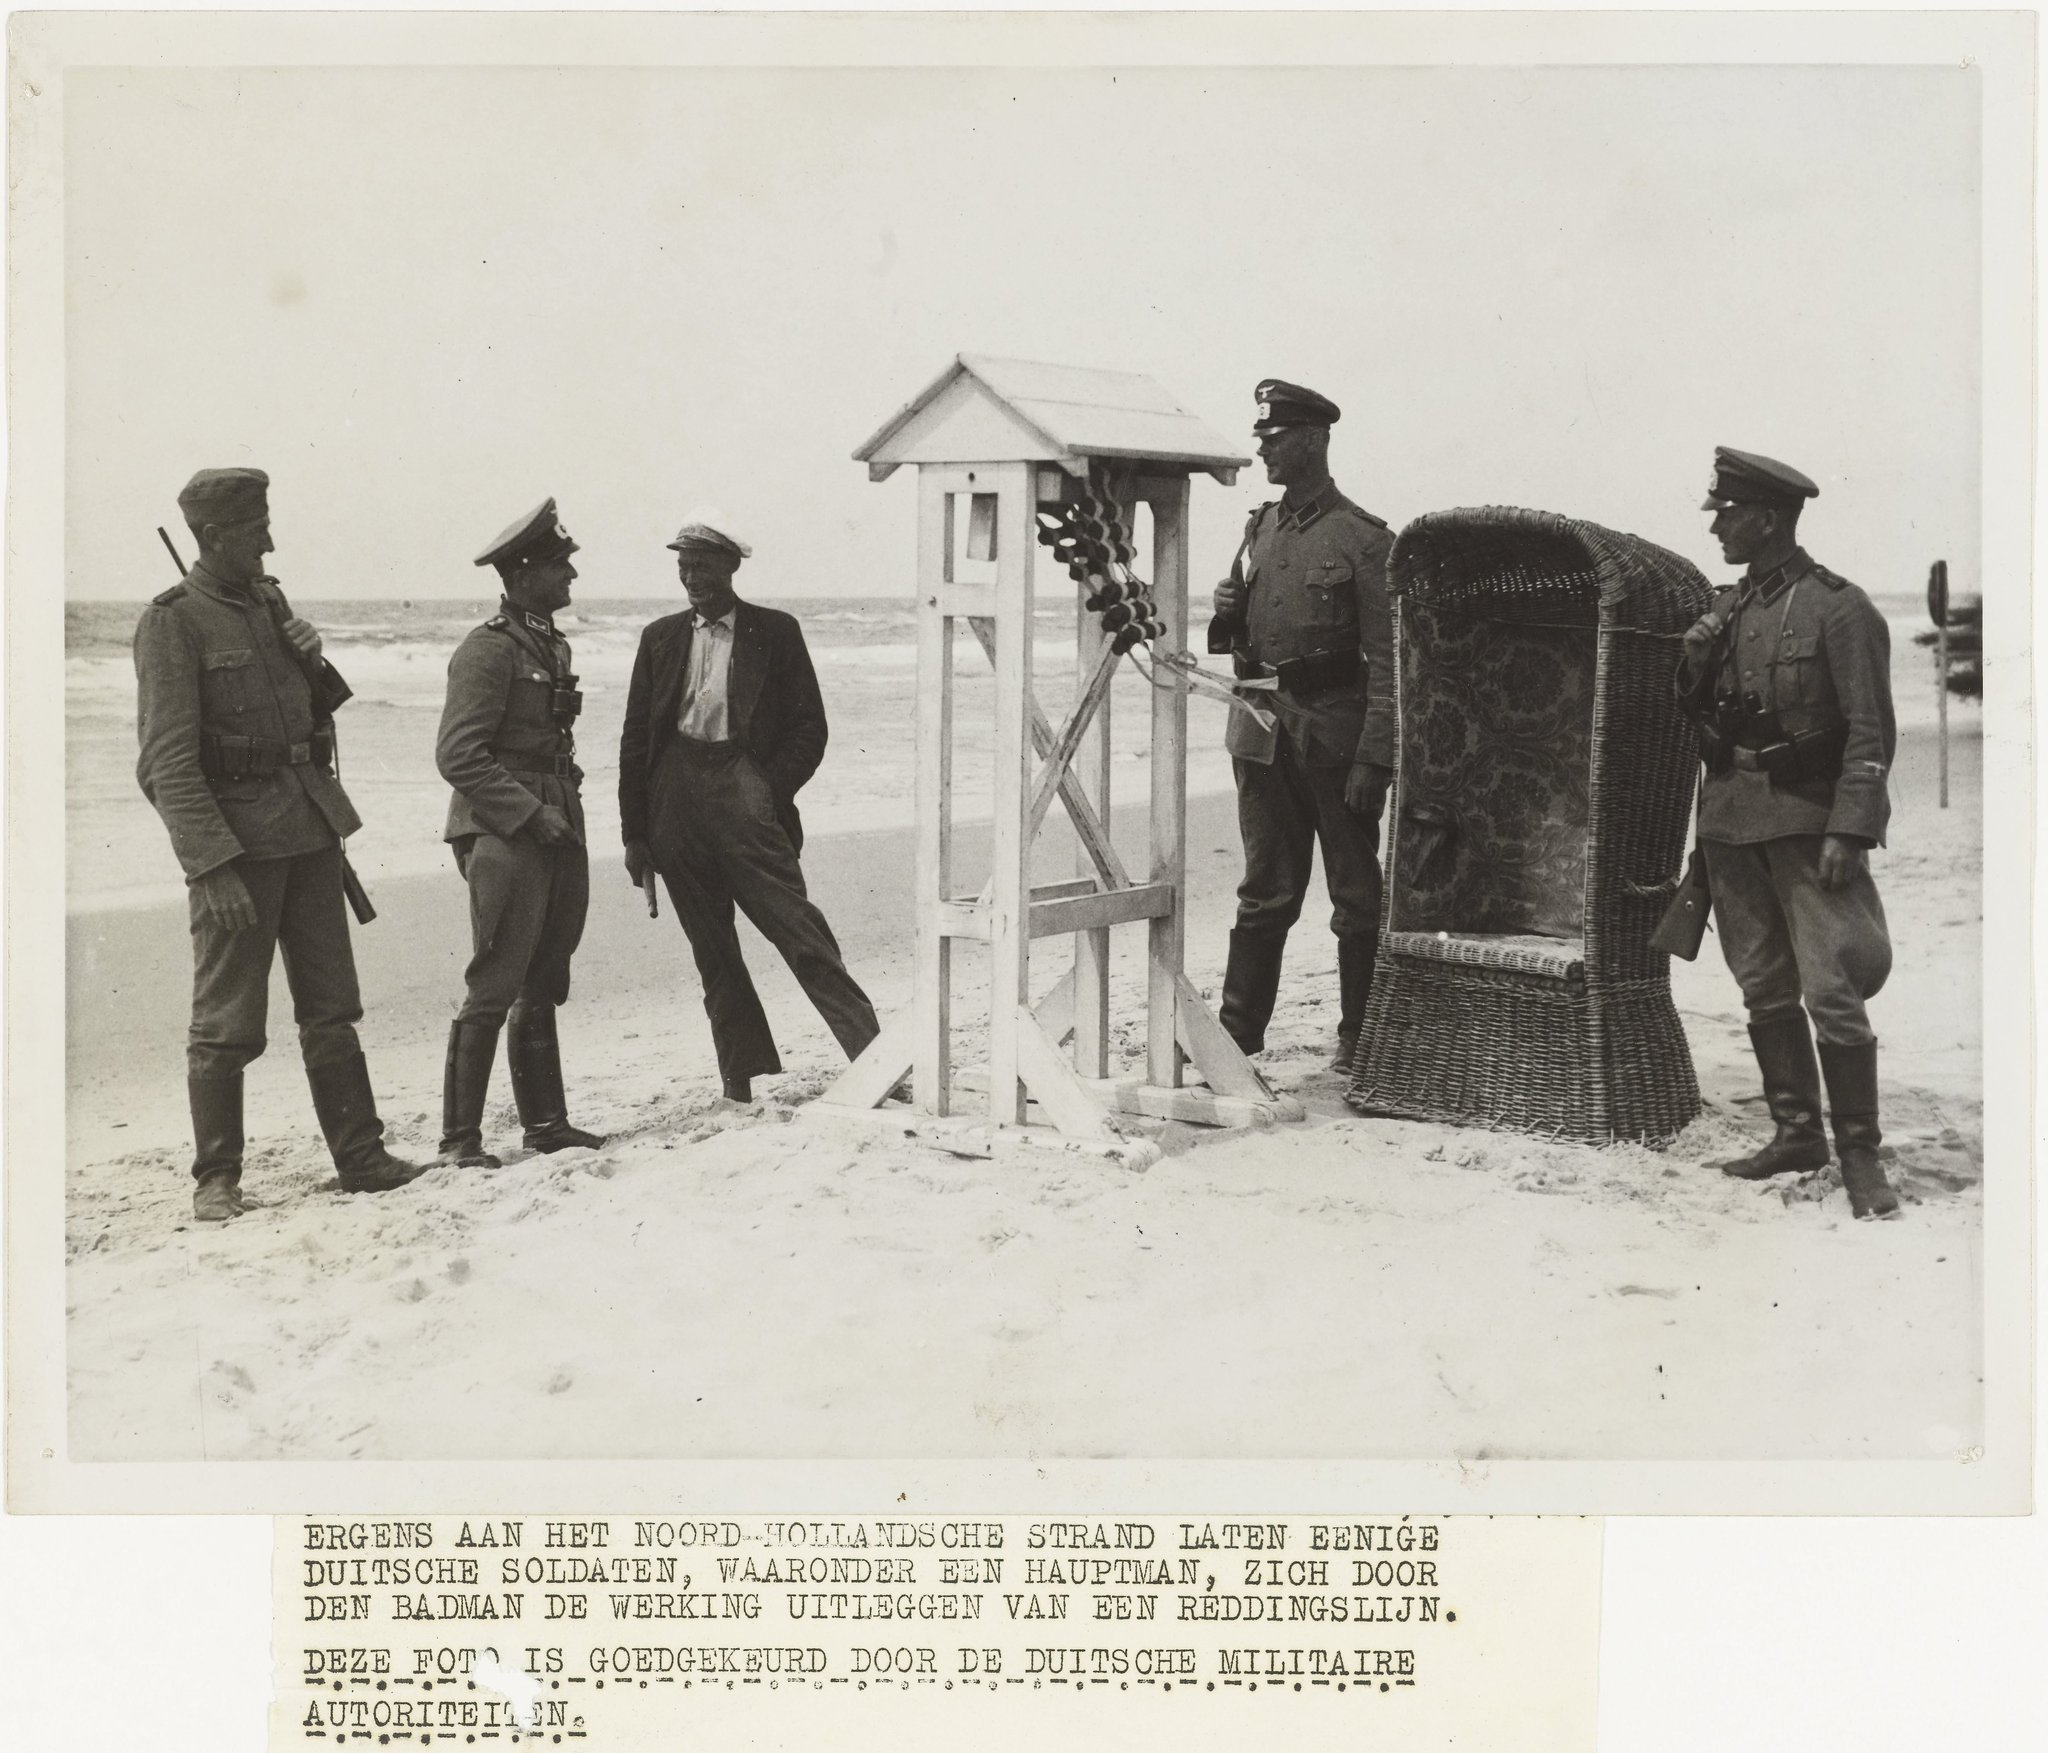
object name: photograph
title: Duitse soldaten aan het strand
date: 1940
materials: photographic support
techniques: photography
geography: north holland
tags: beach (as place of recreation), soldiers and civilians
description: Duitse soldaten aan het strand krijgen van de badmeester uitleg over de werking van de reddingslijn. Tekststrookje aan foto geplakt.